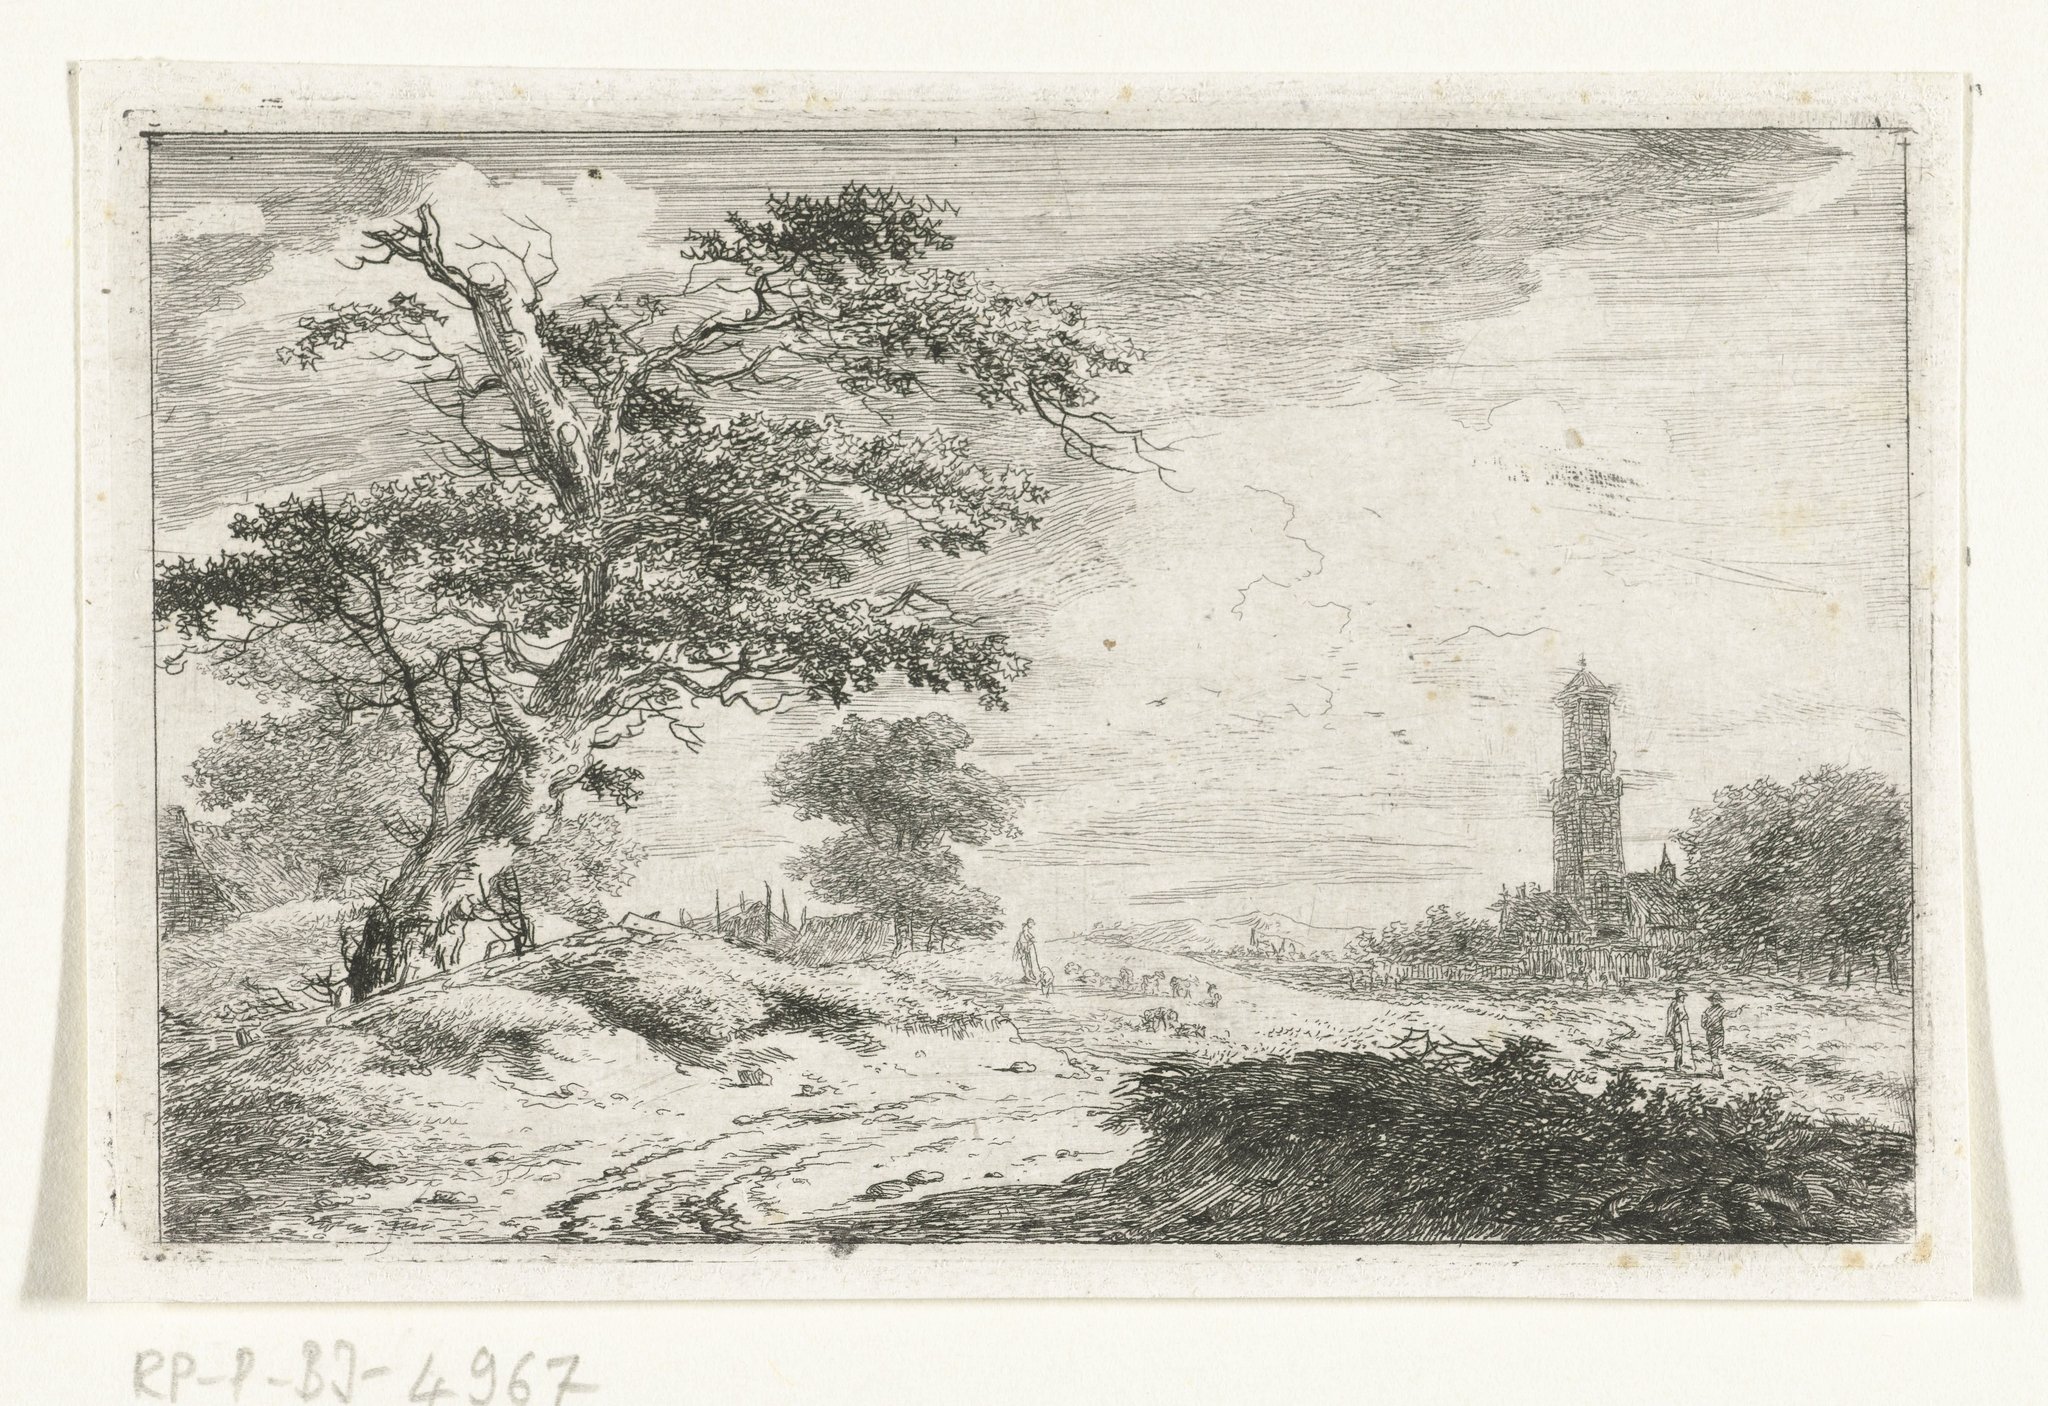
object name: print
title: Kerktoren bij zandvlakte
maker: hermanus van brussel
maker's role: draughtsman, print maker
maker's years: 1763-1815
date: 1800-1815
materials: paper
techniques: etching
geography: netherlands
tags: landscapes in the temperate zone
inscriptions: collector's mark: Lugt 2228